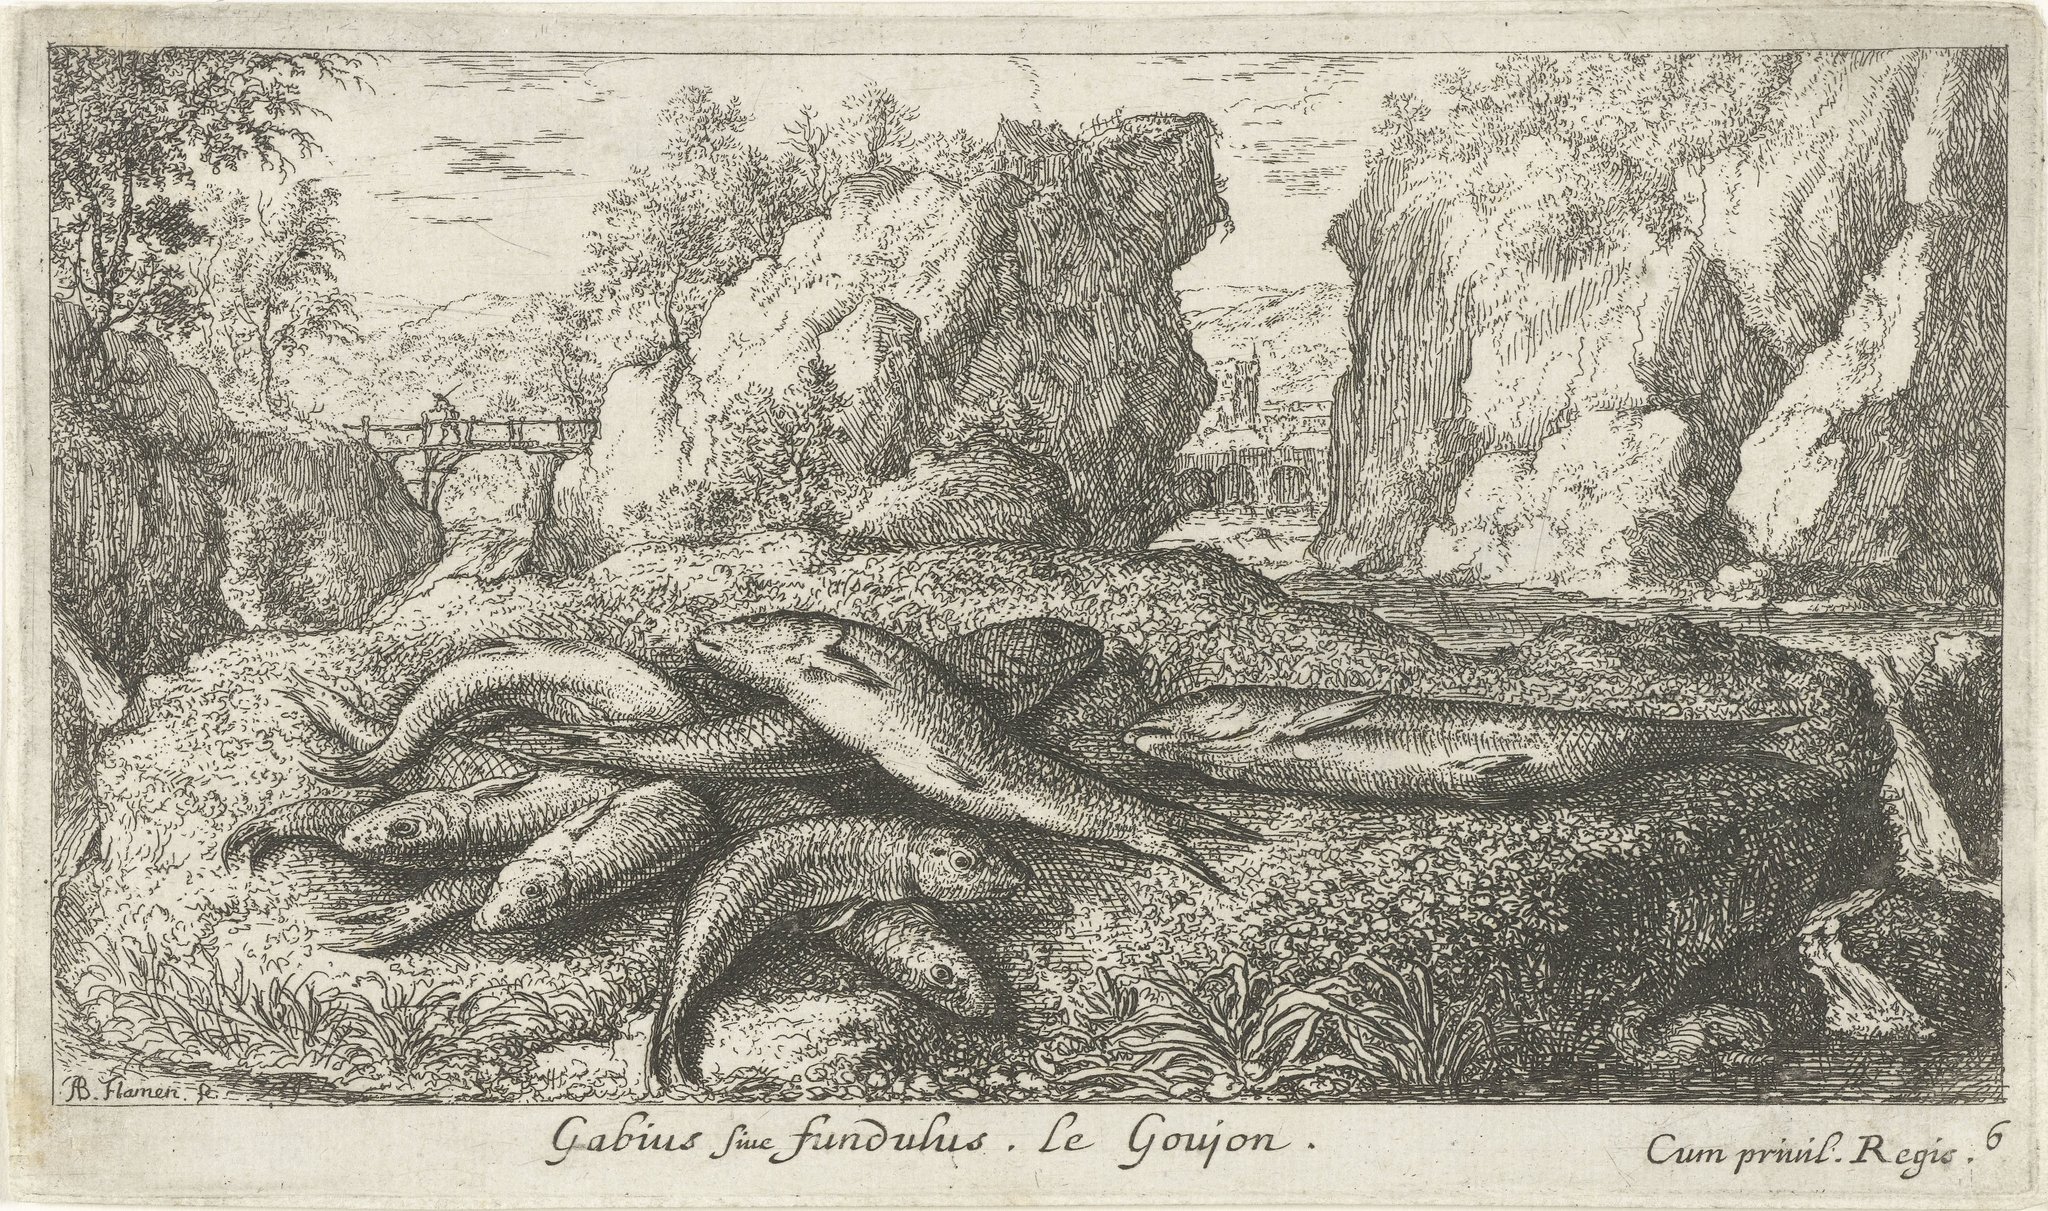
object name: print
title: Grondels op een rivieroever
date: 1664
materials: paper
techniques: etching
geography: paris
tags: fishes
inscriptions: collector's mark: Lugt 2228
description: Rotslandschap met op de voorgrond vissen op het gras. Op de achtergrond een brug over de rivier.